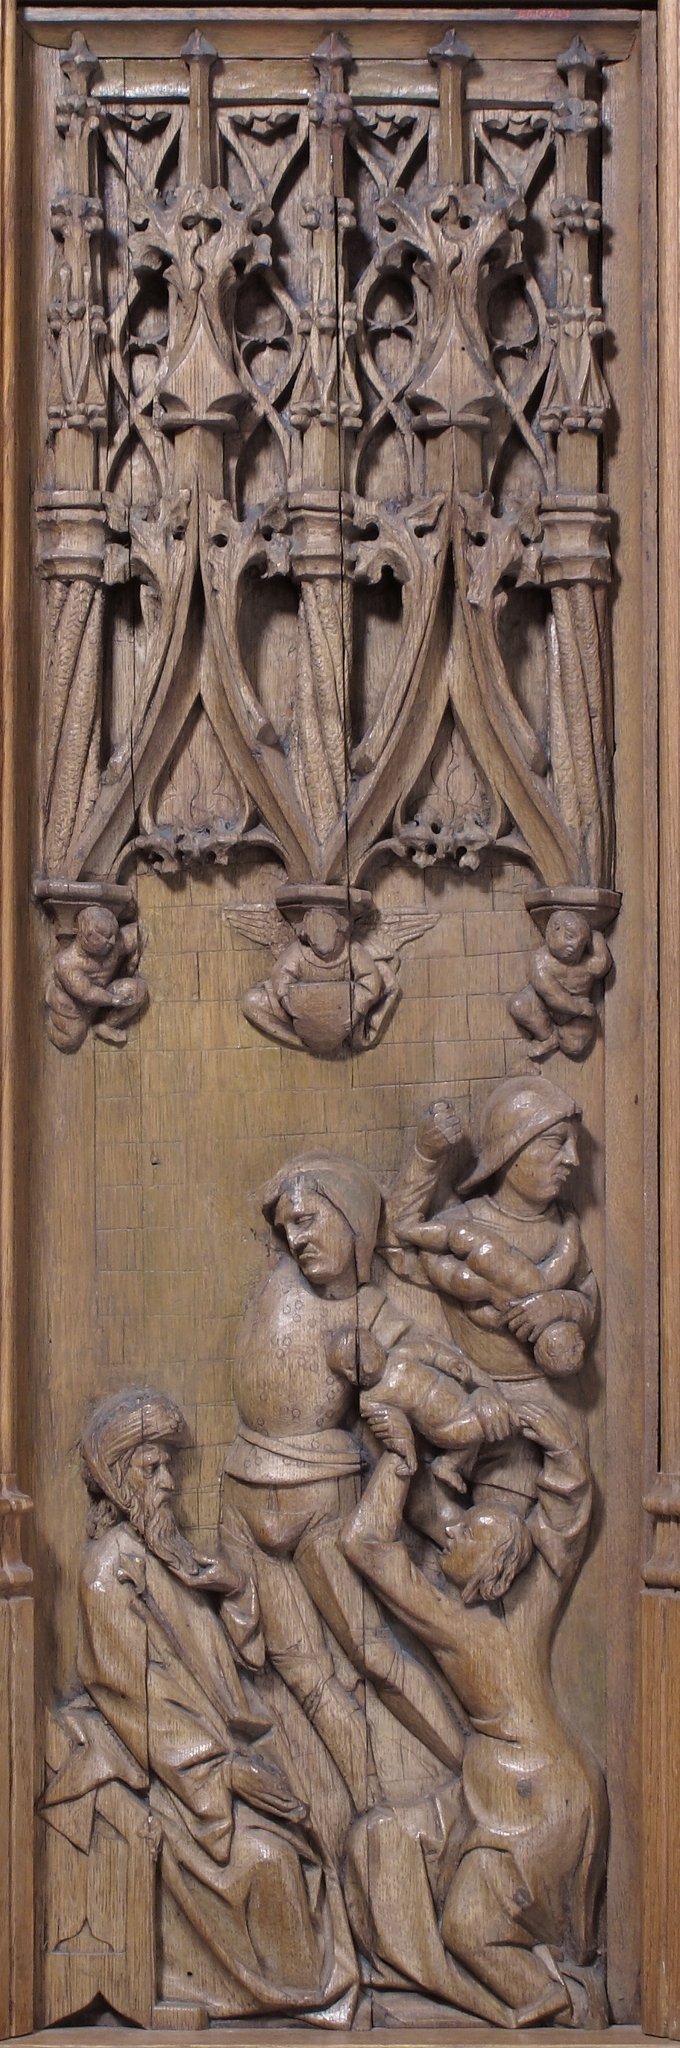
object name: panel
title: Panel with the Massacre of the Innocents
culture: french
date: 1501-1533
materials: wood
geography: france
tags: massacres,infants,men,women